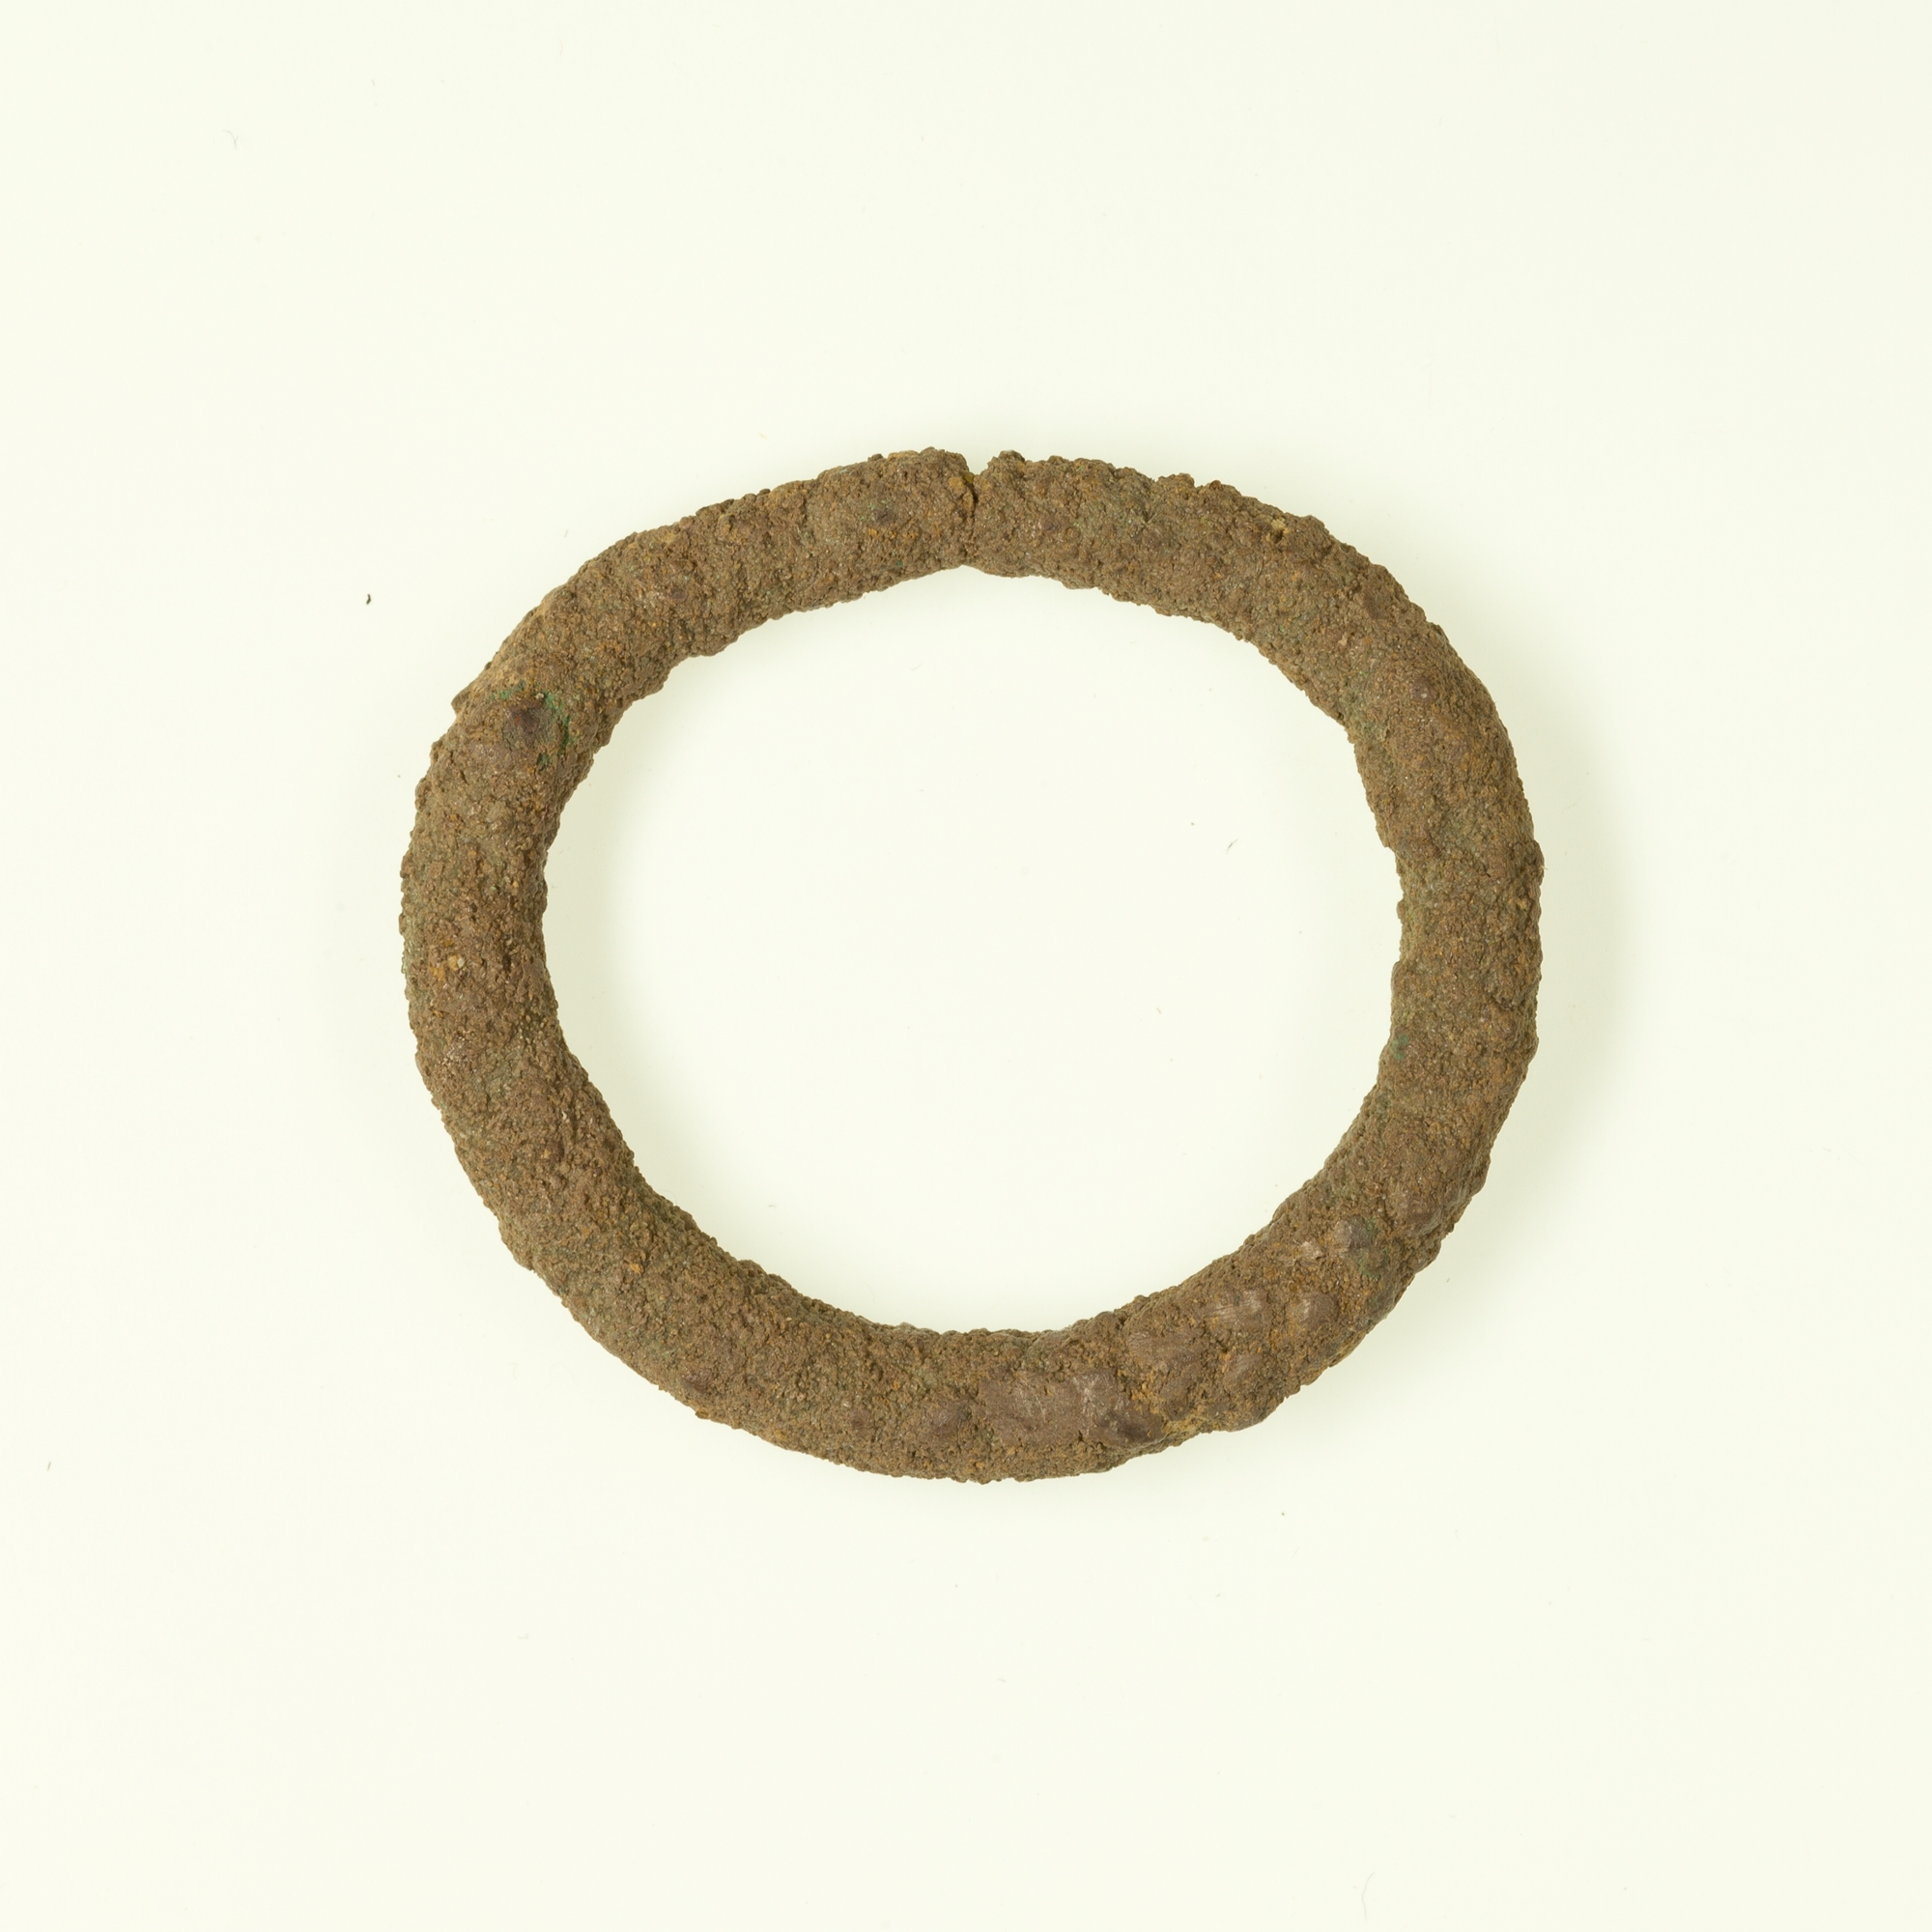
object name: household ring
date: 1295-1070 BCE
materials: bronze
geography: egypt